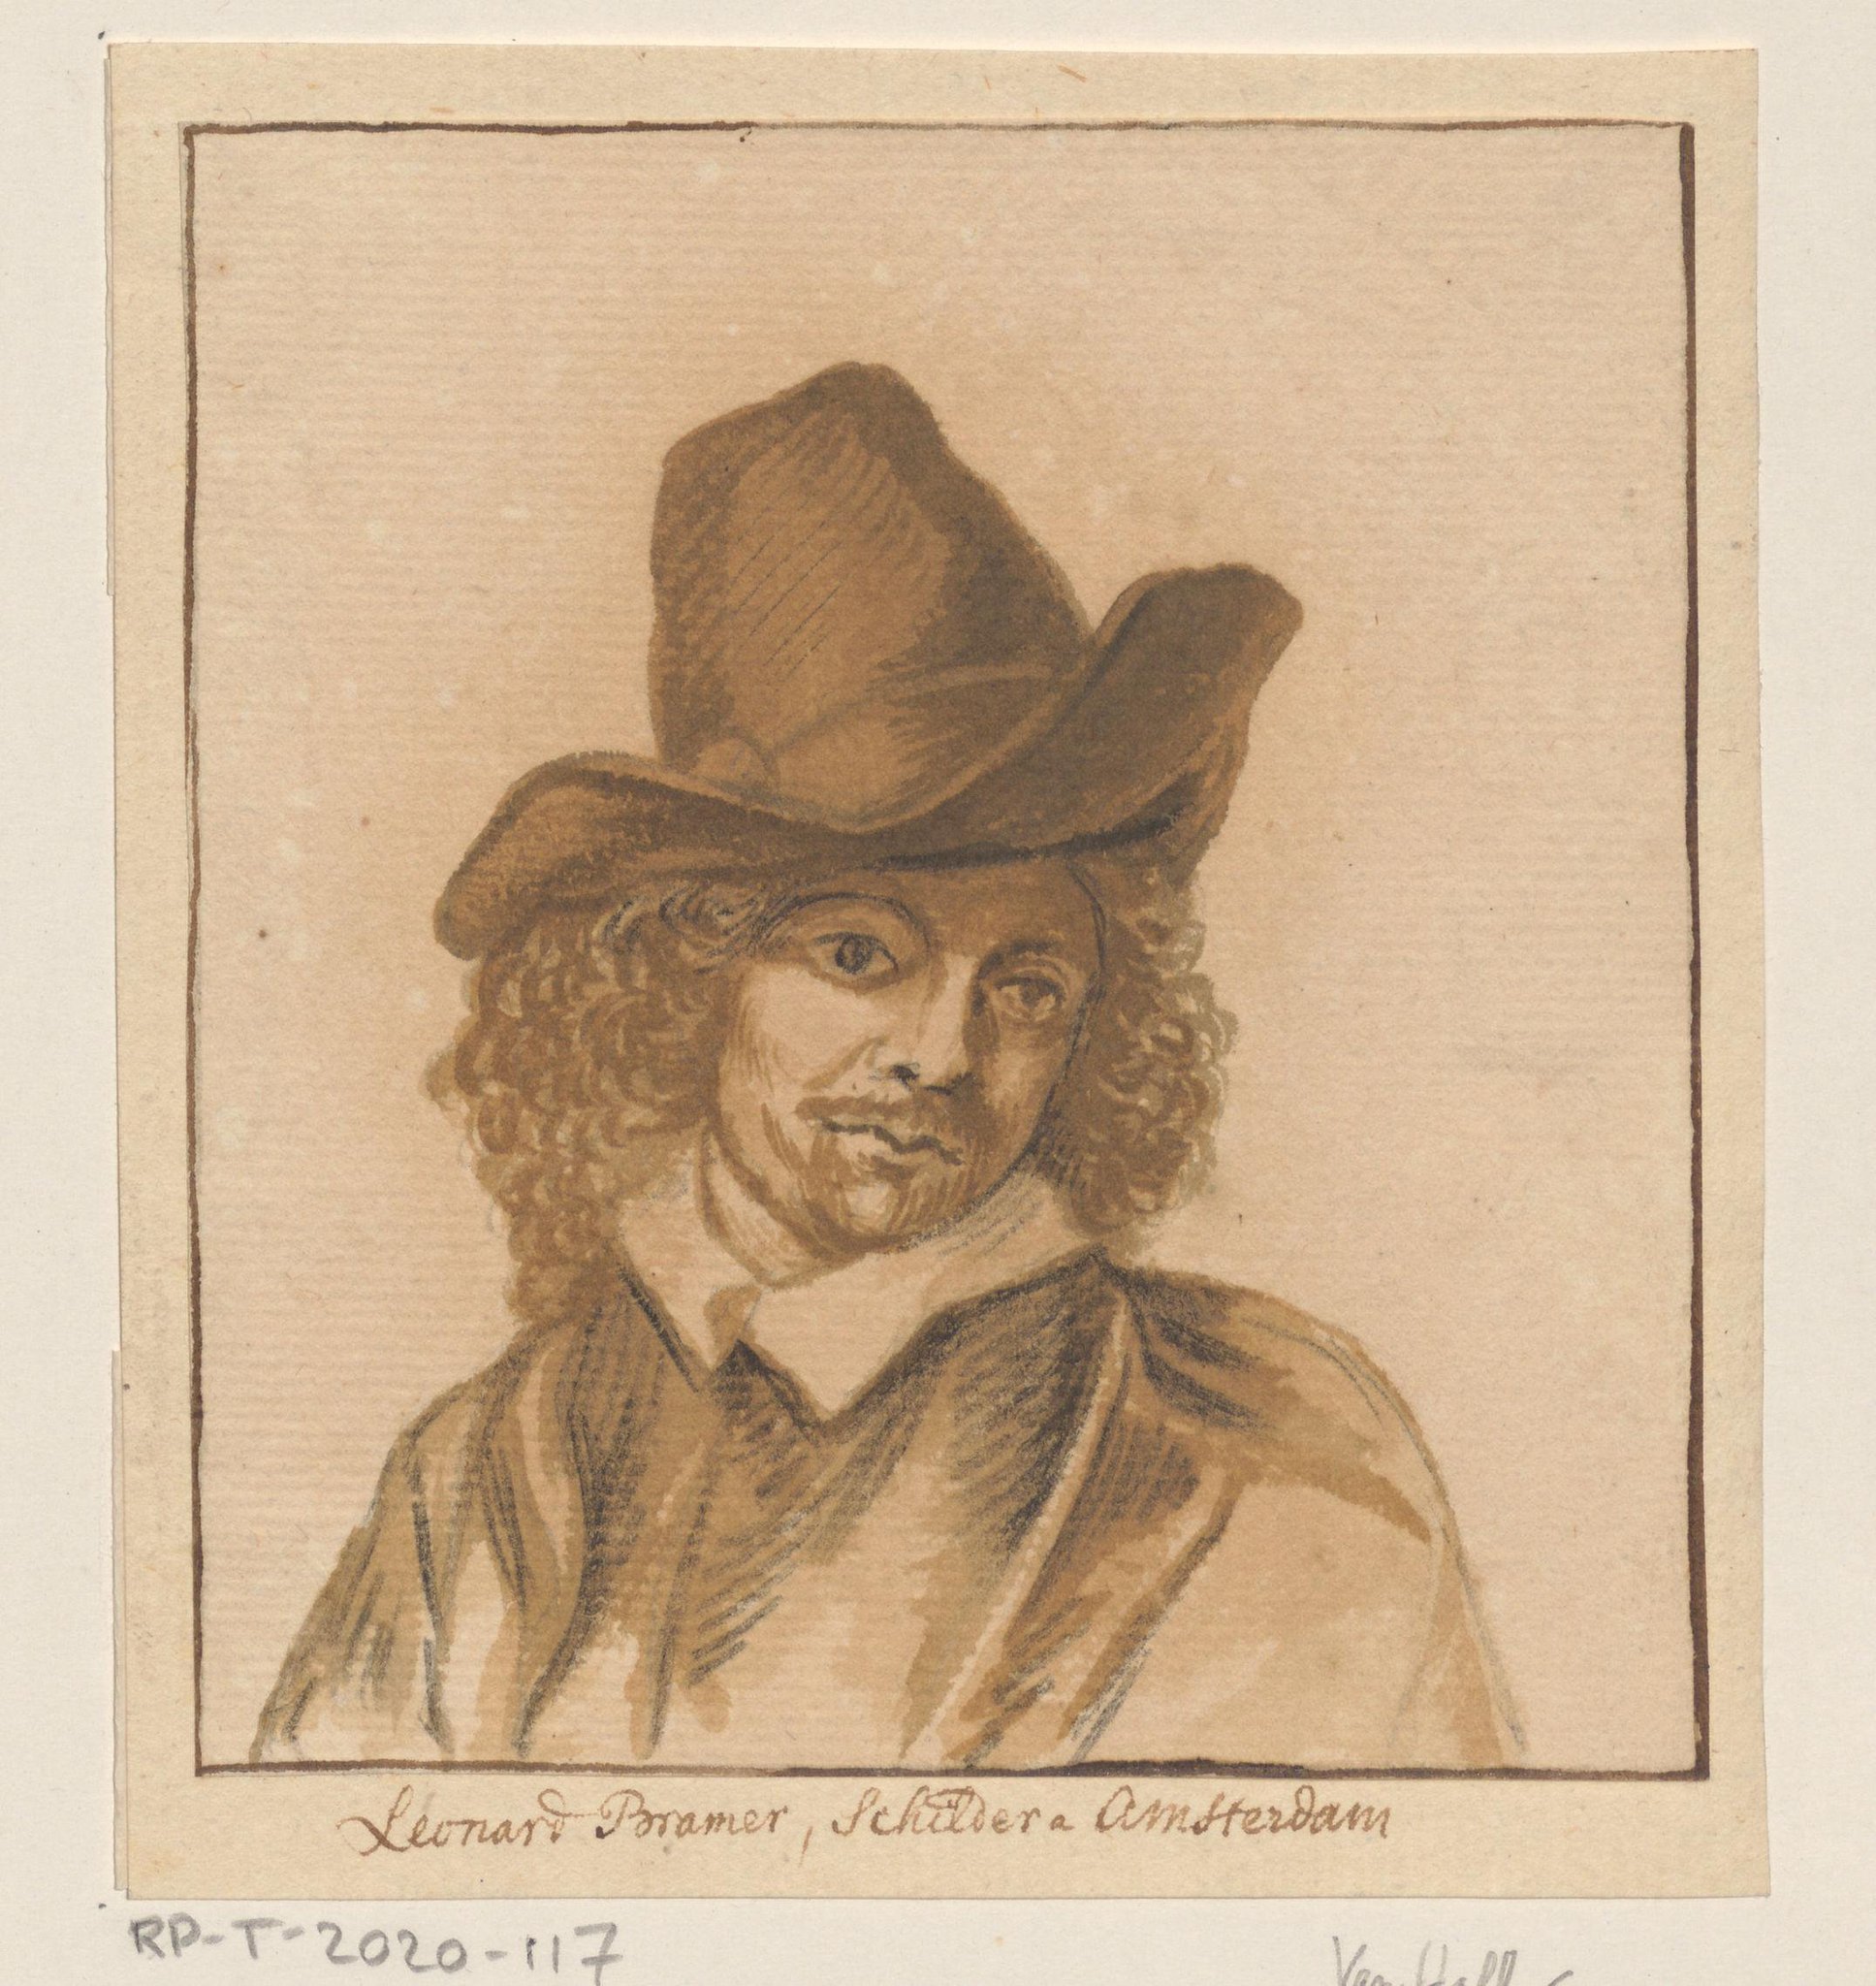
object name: drawing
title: Portret van Leonaert Bramer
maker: Anonymous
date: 1700-1799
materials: paper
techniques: brush, pen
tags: delft, painter, print maker, draughtsman, leonaert bramer, historical persons, portrait, self-portrait of artist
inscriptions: inscription: ‘Leonard Bramer, schilder a Amsterdam’